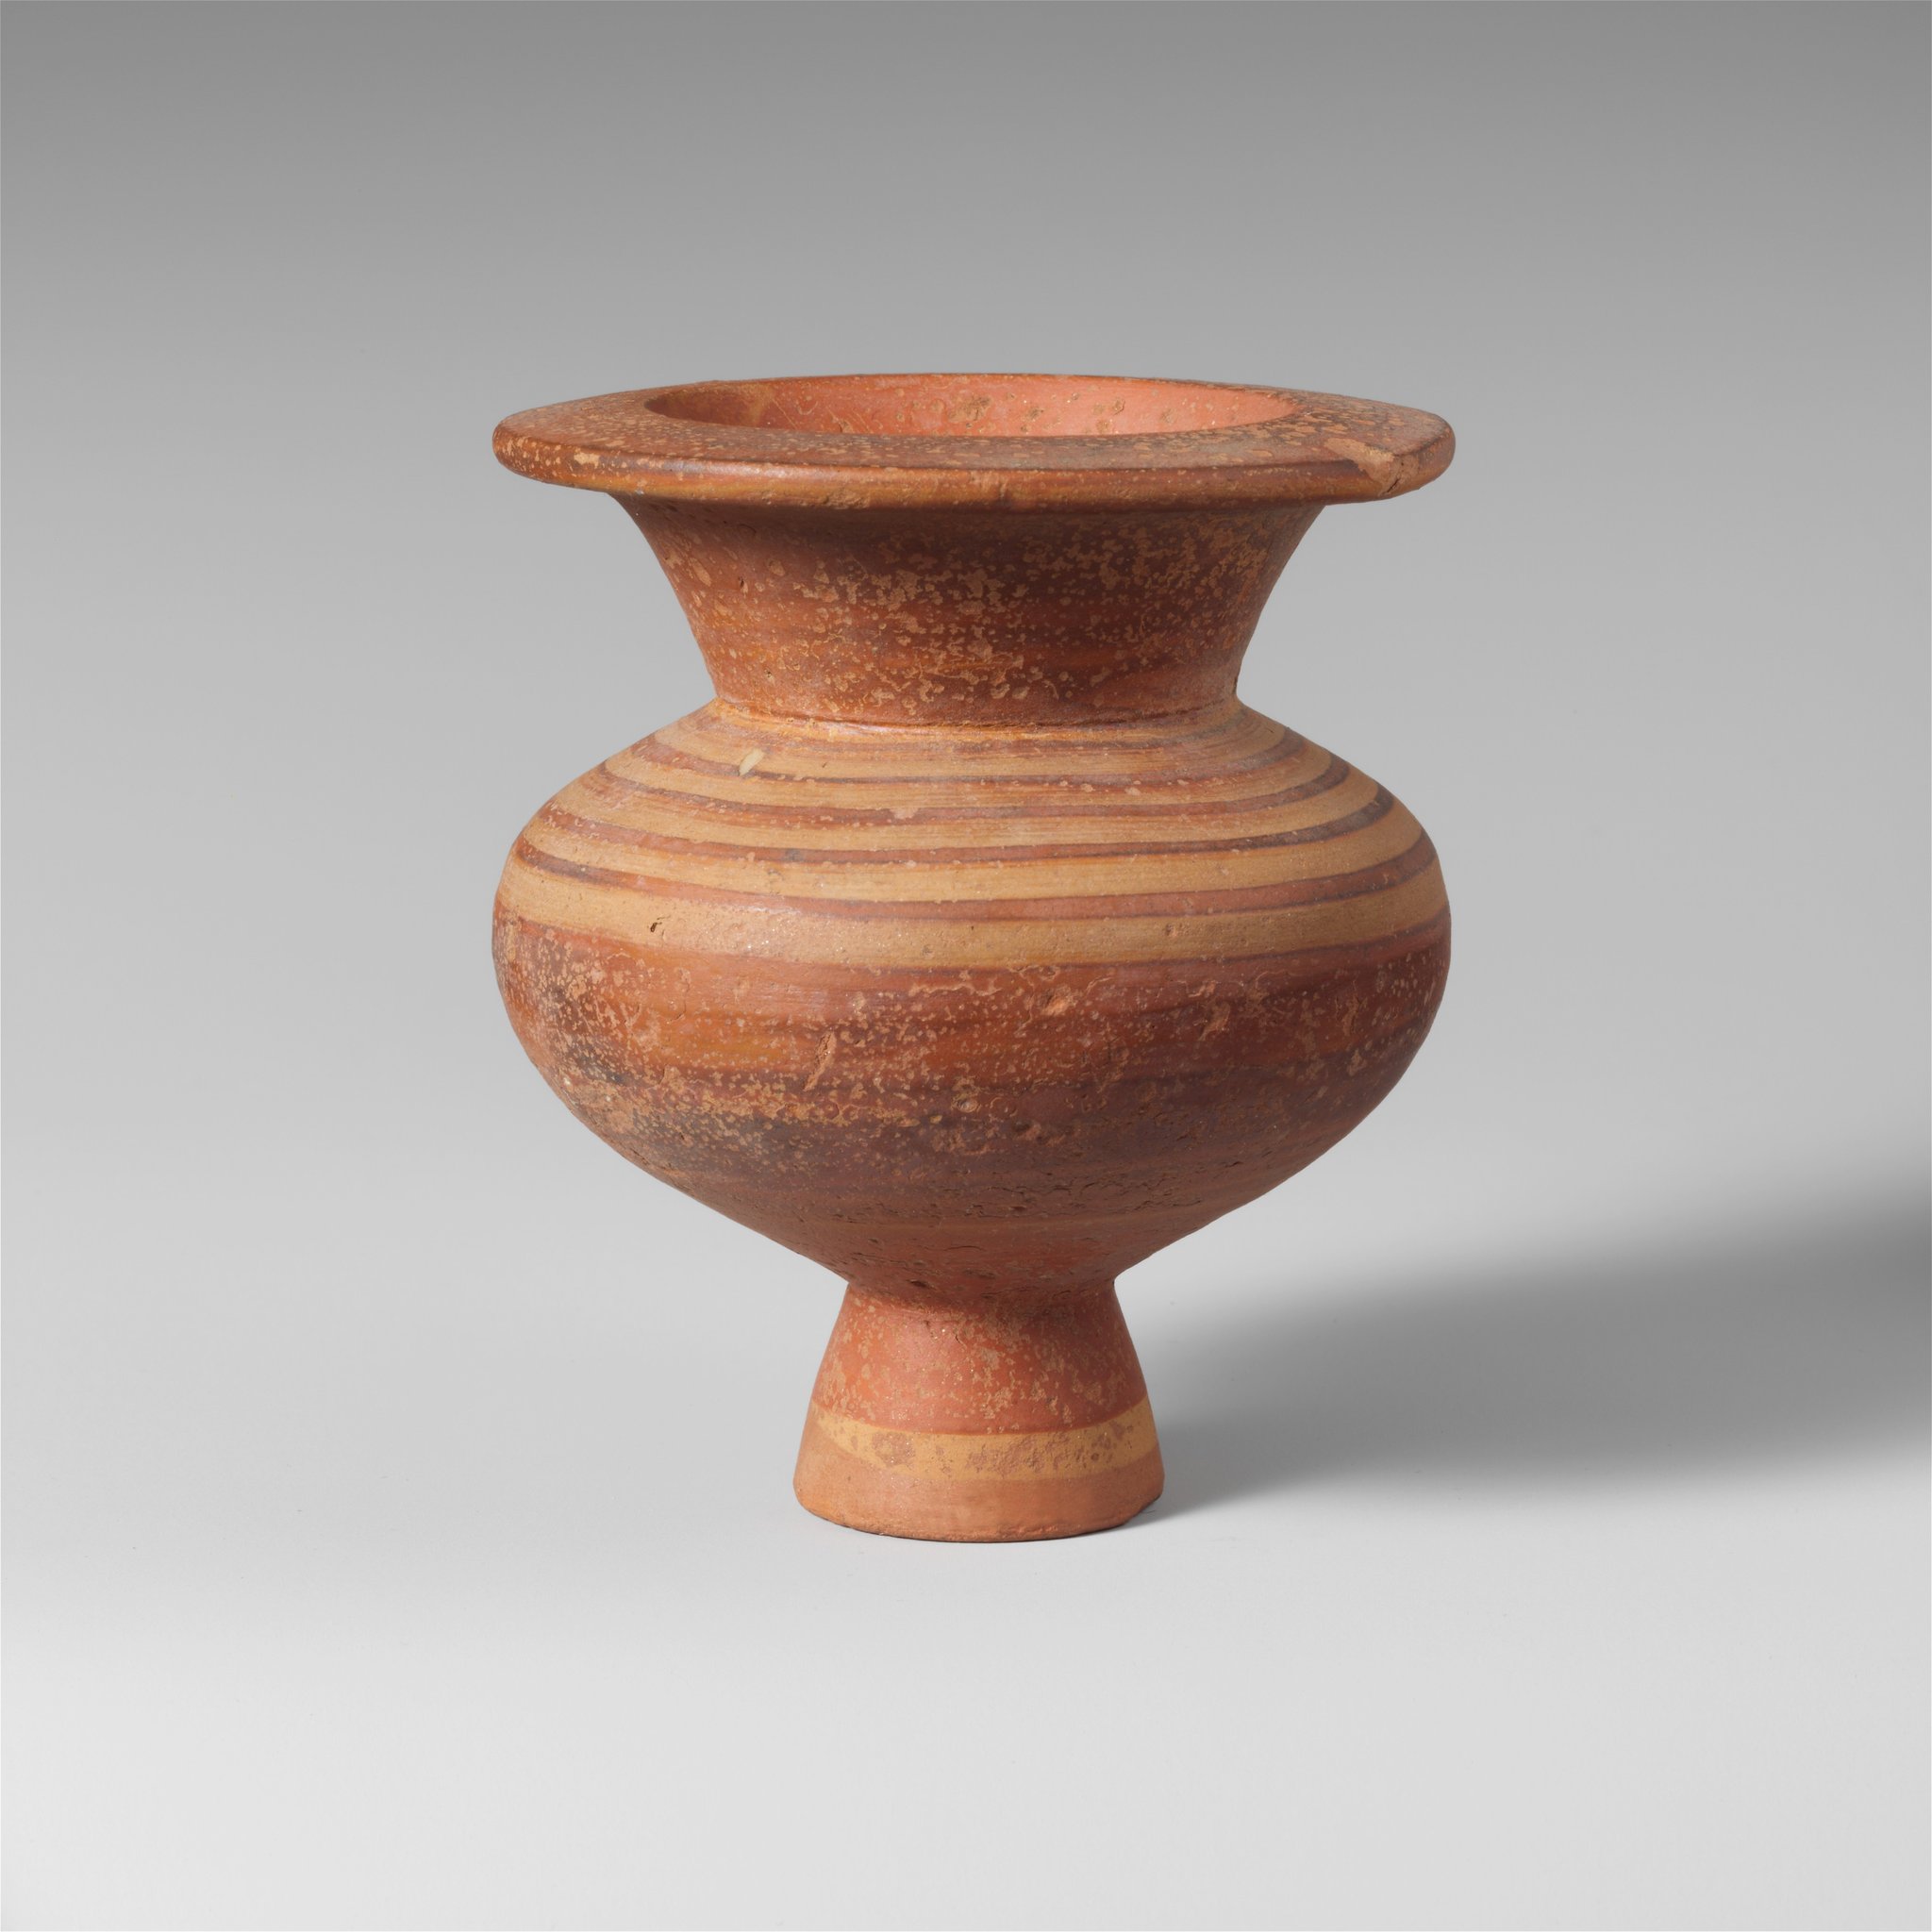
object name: lydion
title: Terracotta lydion (perfume jar)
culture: lydian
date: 600-501 BCE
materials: terracotta